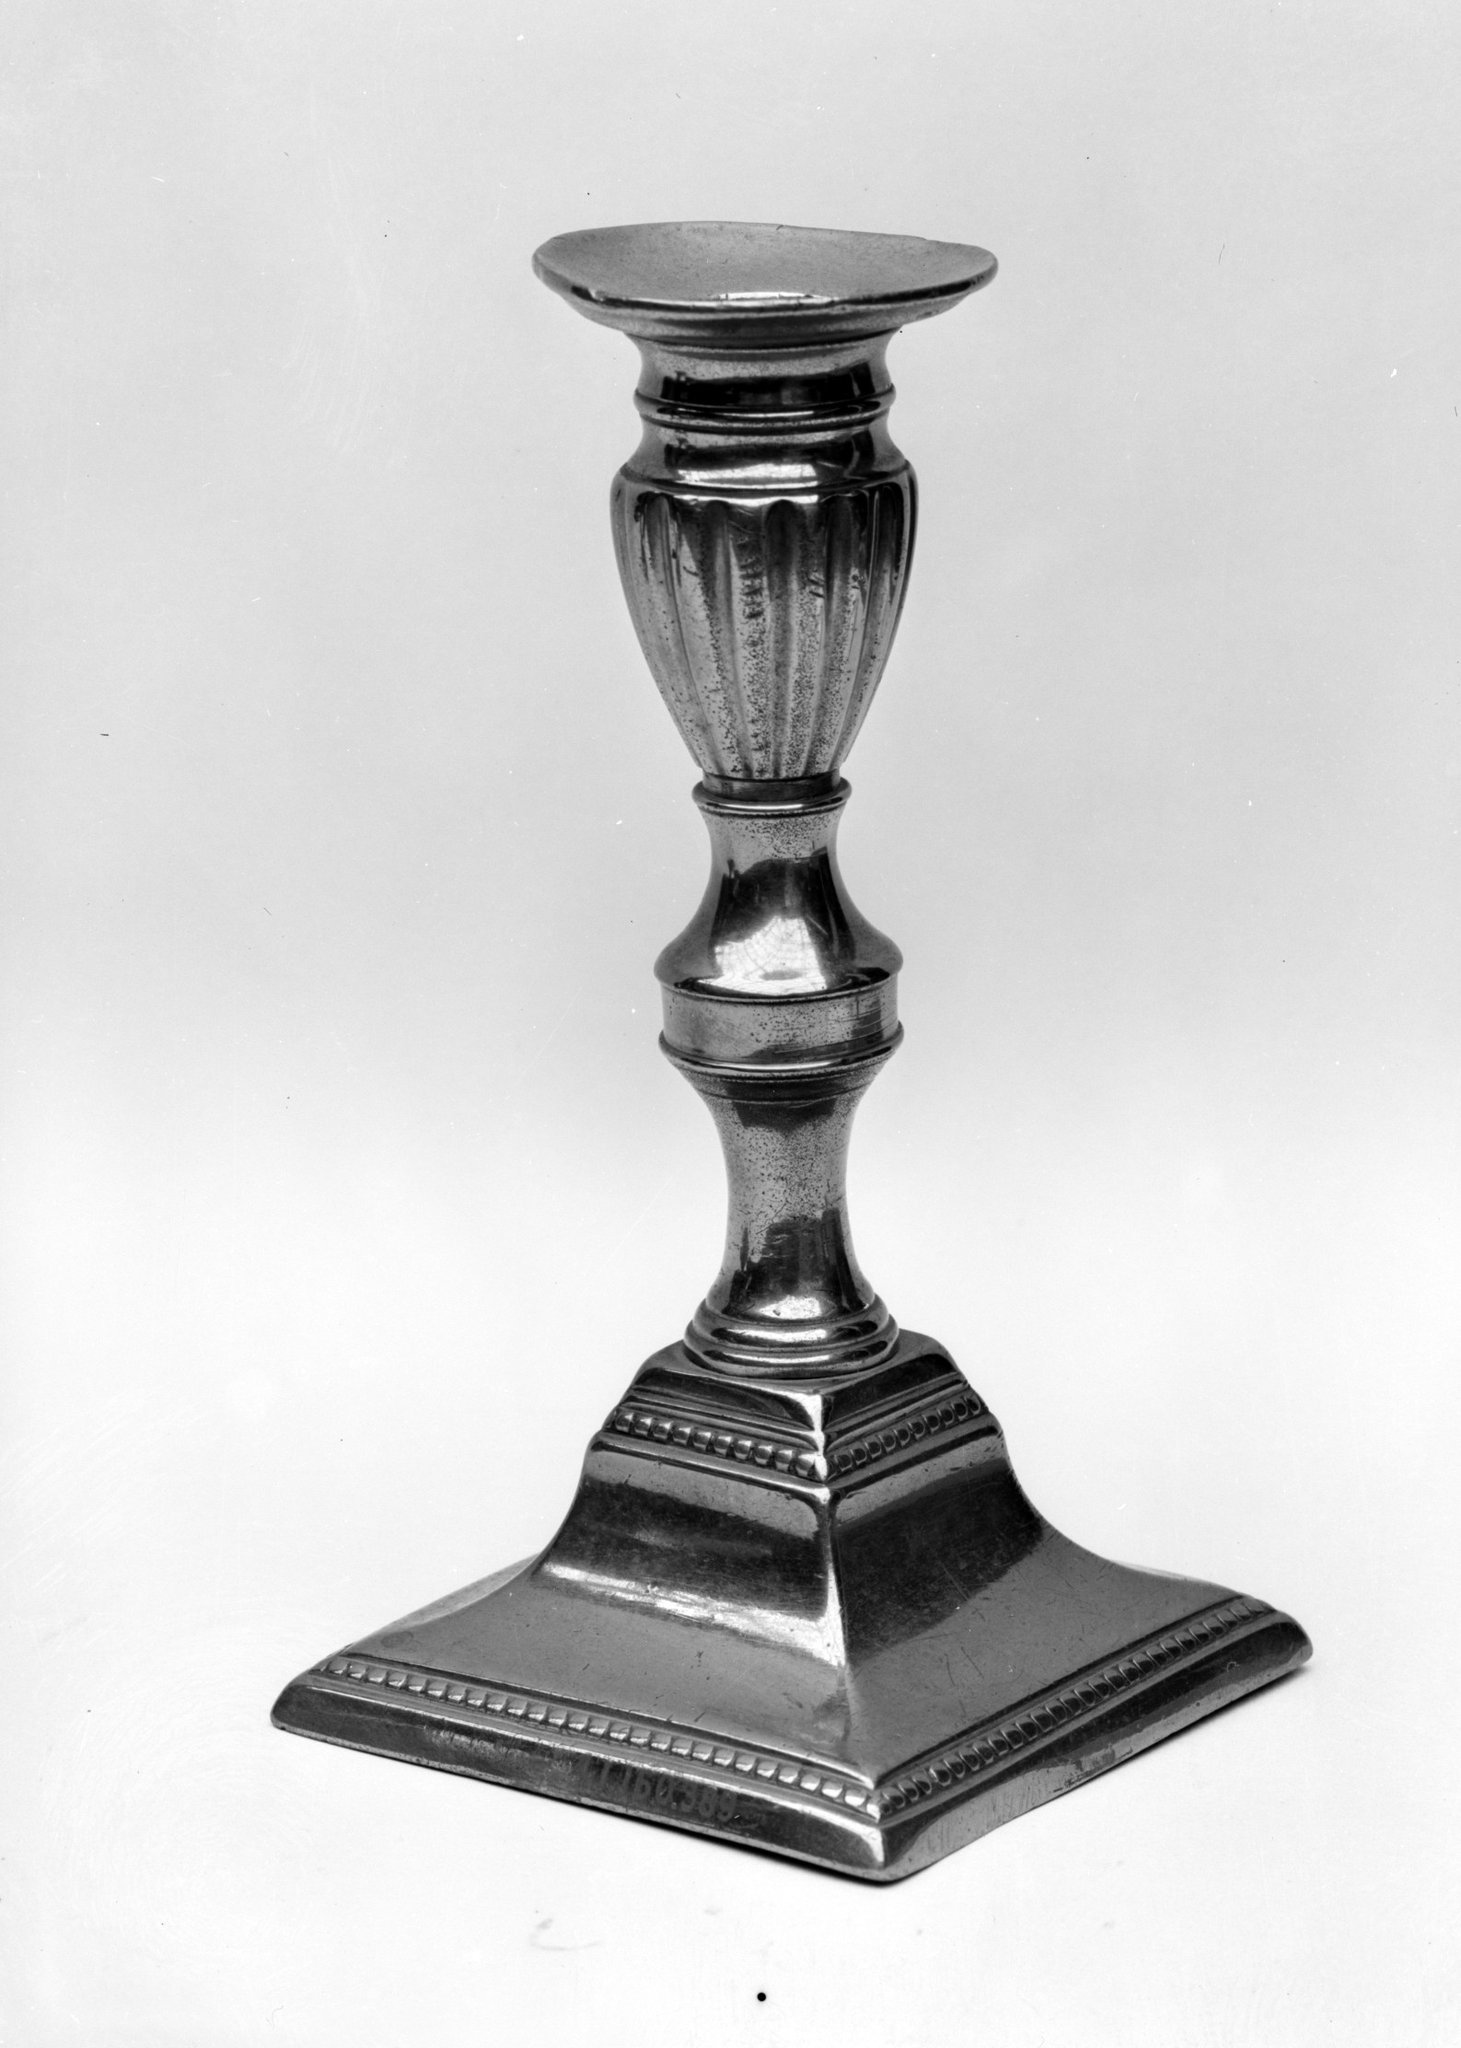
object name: candlestick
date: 1770-1800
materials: brass